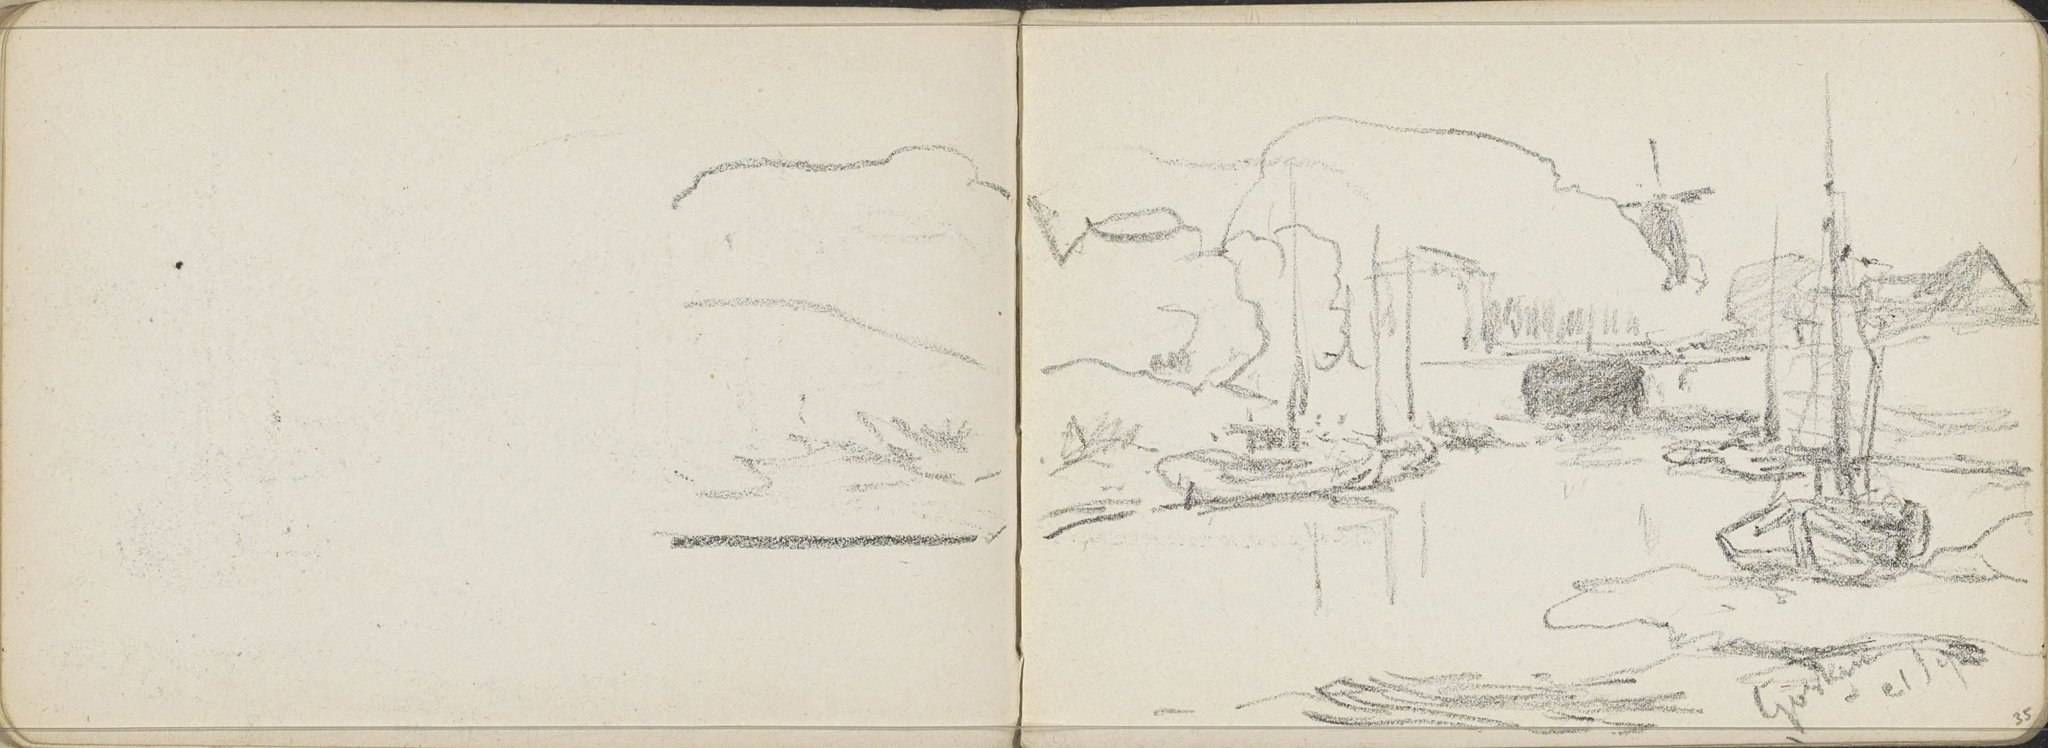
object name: sketchbook leaf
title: Aangemeerde zeilboten aan een waterkant te Gorinchem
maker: willem cornelis rip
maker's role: draughtsman, painter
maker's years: 1856-1922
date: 1905-1909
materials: chalk, paper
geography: gorinchem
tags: sailing-ship, sailing-boat, landscapes with waters, waterscapes, seascapes (in the temperate zone)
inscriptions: date and inscription: ‘Gorinchem/21 Se[...]’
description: Blad 34 verso en 35 recto uit een schetsboek met 42 bladen.